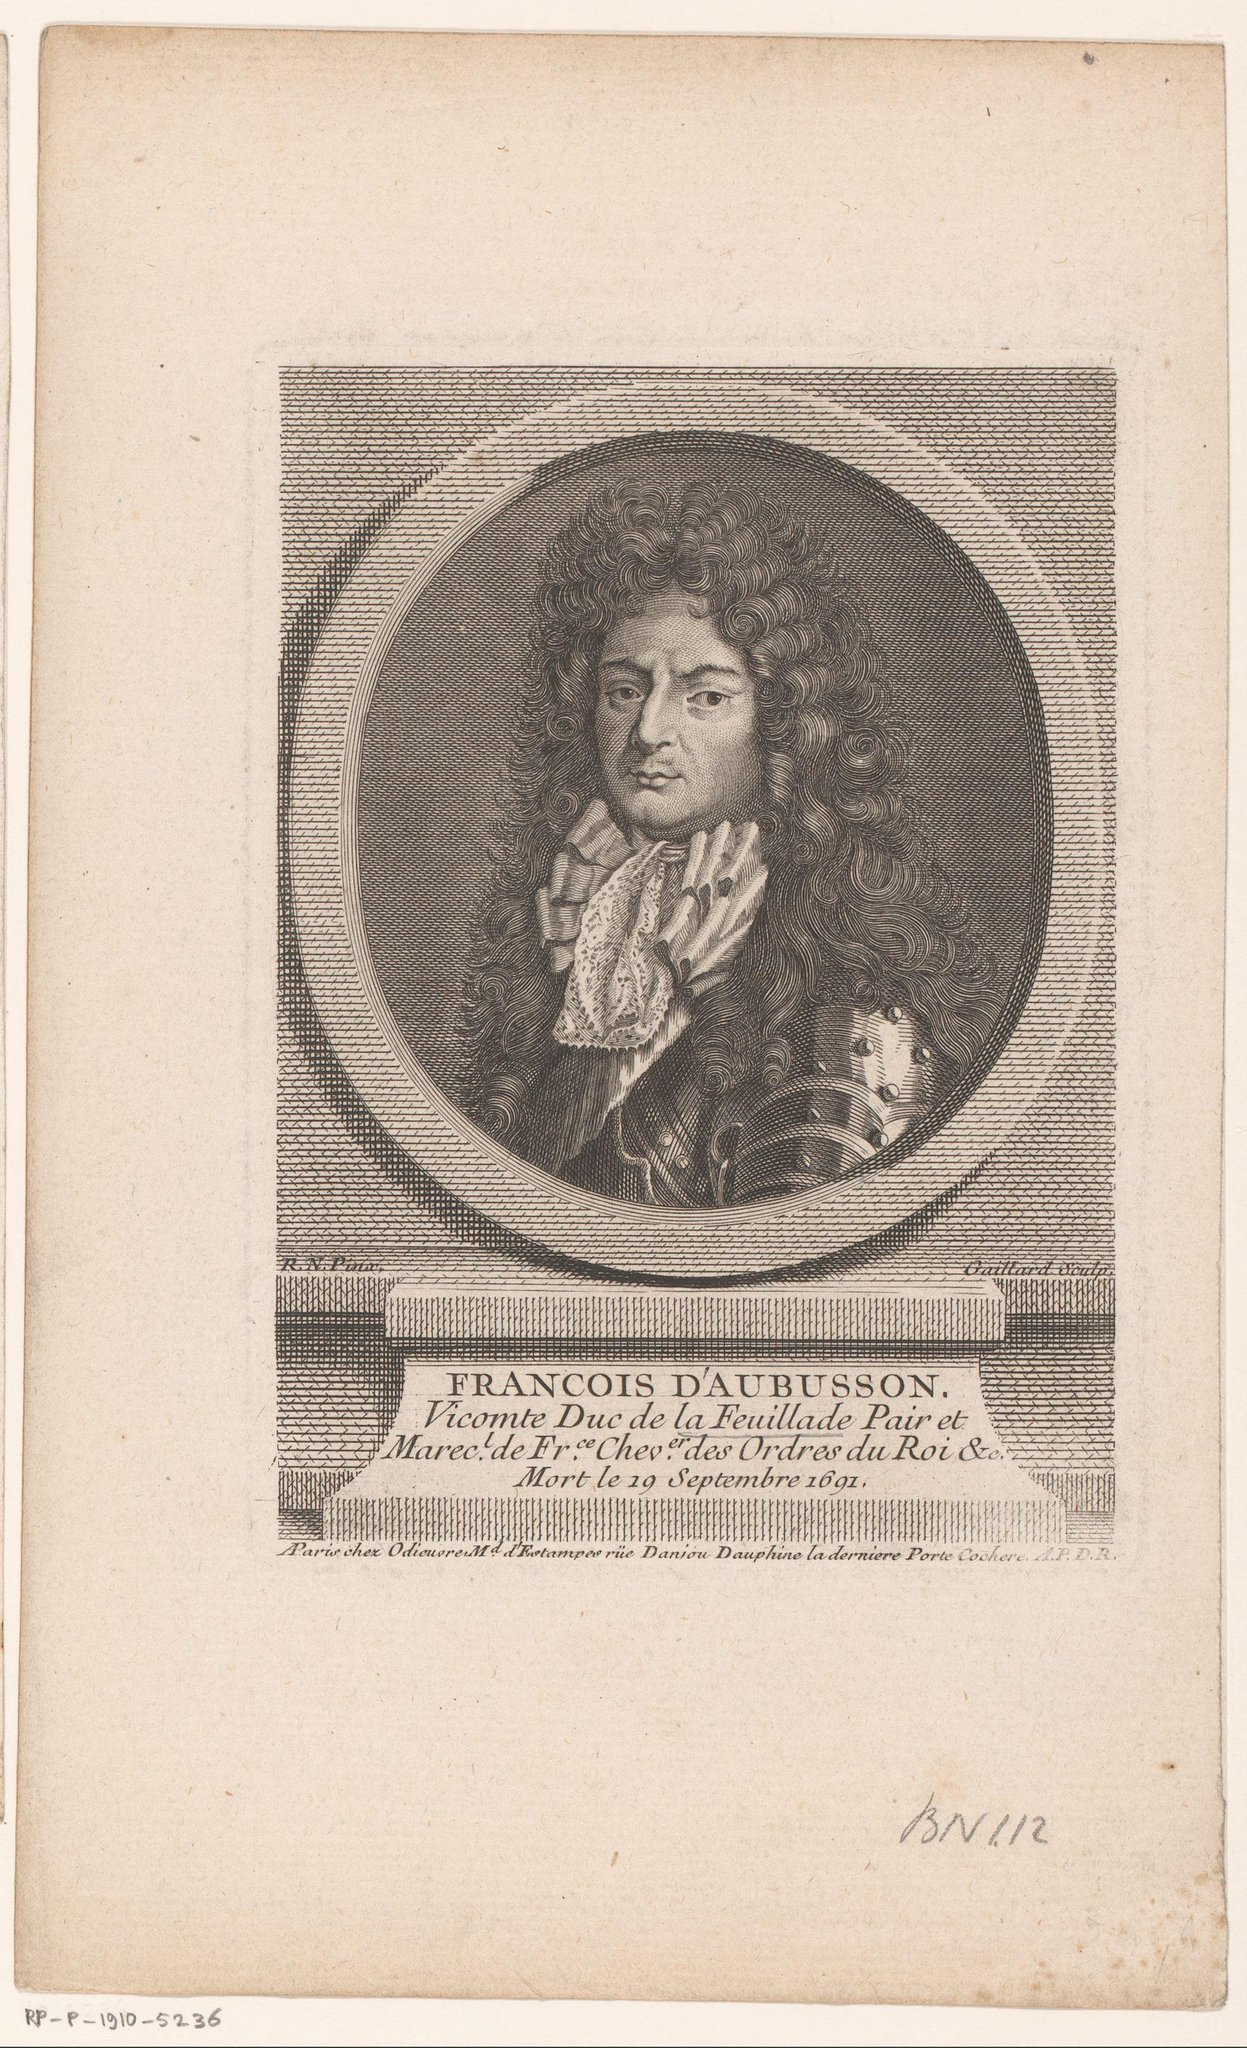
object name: book illustration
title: Portret van François d'Aubusson de La Feuillade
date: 1755-1765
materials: paper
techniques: engraving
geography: paris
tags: historical persons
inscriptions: collector's mark: Lugt 2228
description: Mogelijk prent uit: Dreux du Radier, Jean-François. L'Europe illustré, contenant l'histoire abregée des souverains, des princes, des prélats, des ministres, (...) en Europe: dans le XVe. siècle compris, jusqu'à présent. Parijs: Michel Odieuvre en André-François Le Breton, 1755-1765, dl. 4.